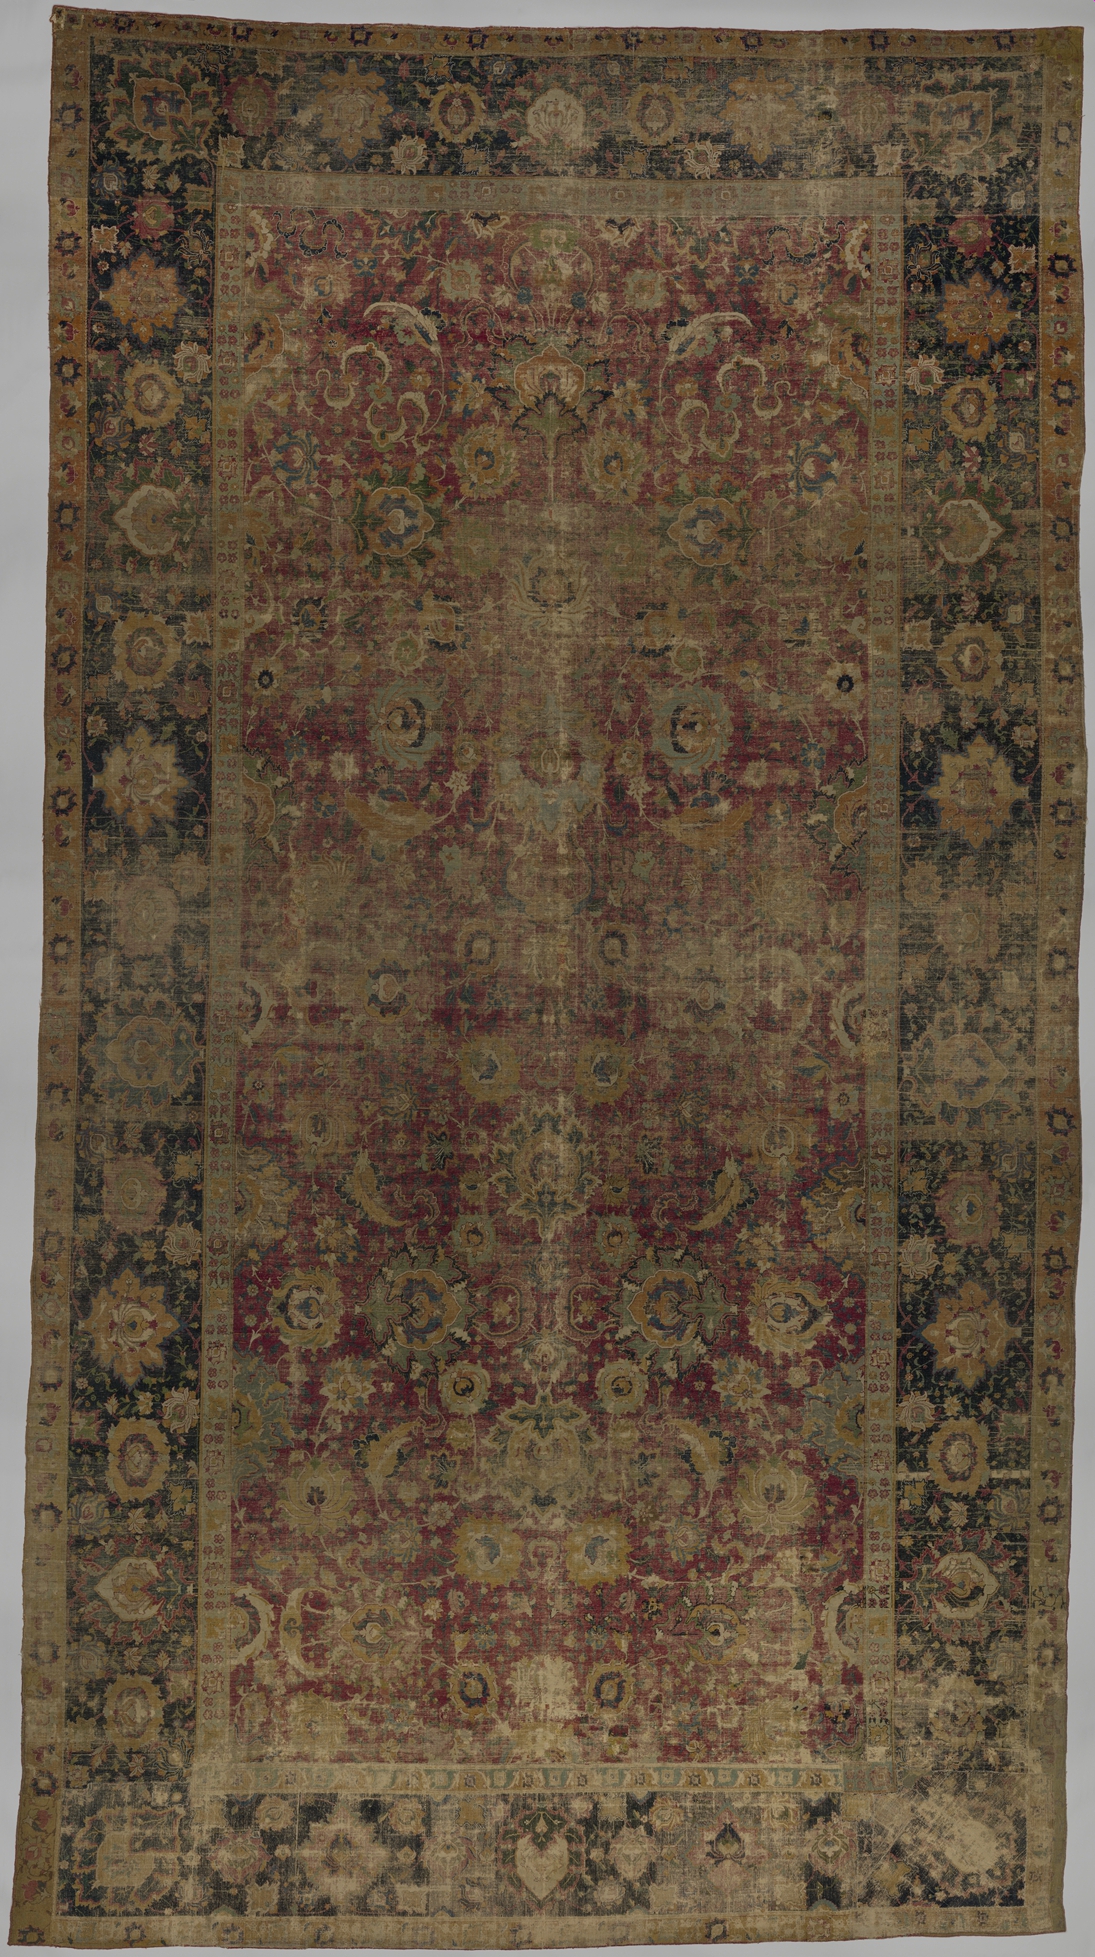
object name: carpet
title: Indo-Persian carpet with vine scroll and palmette pattern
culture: indo-persian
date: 1625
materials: cotton, wool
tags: flowers